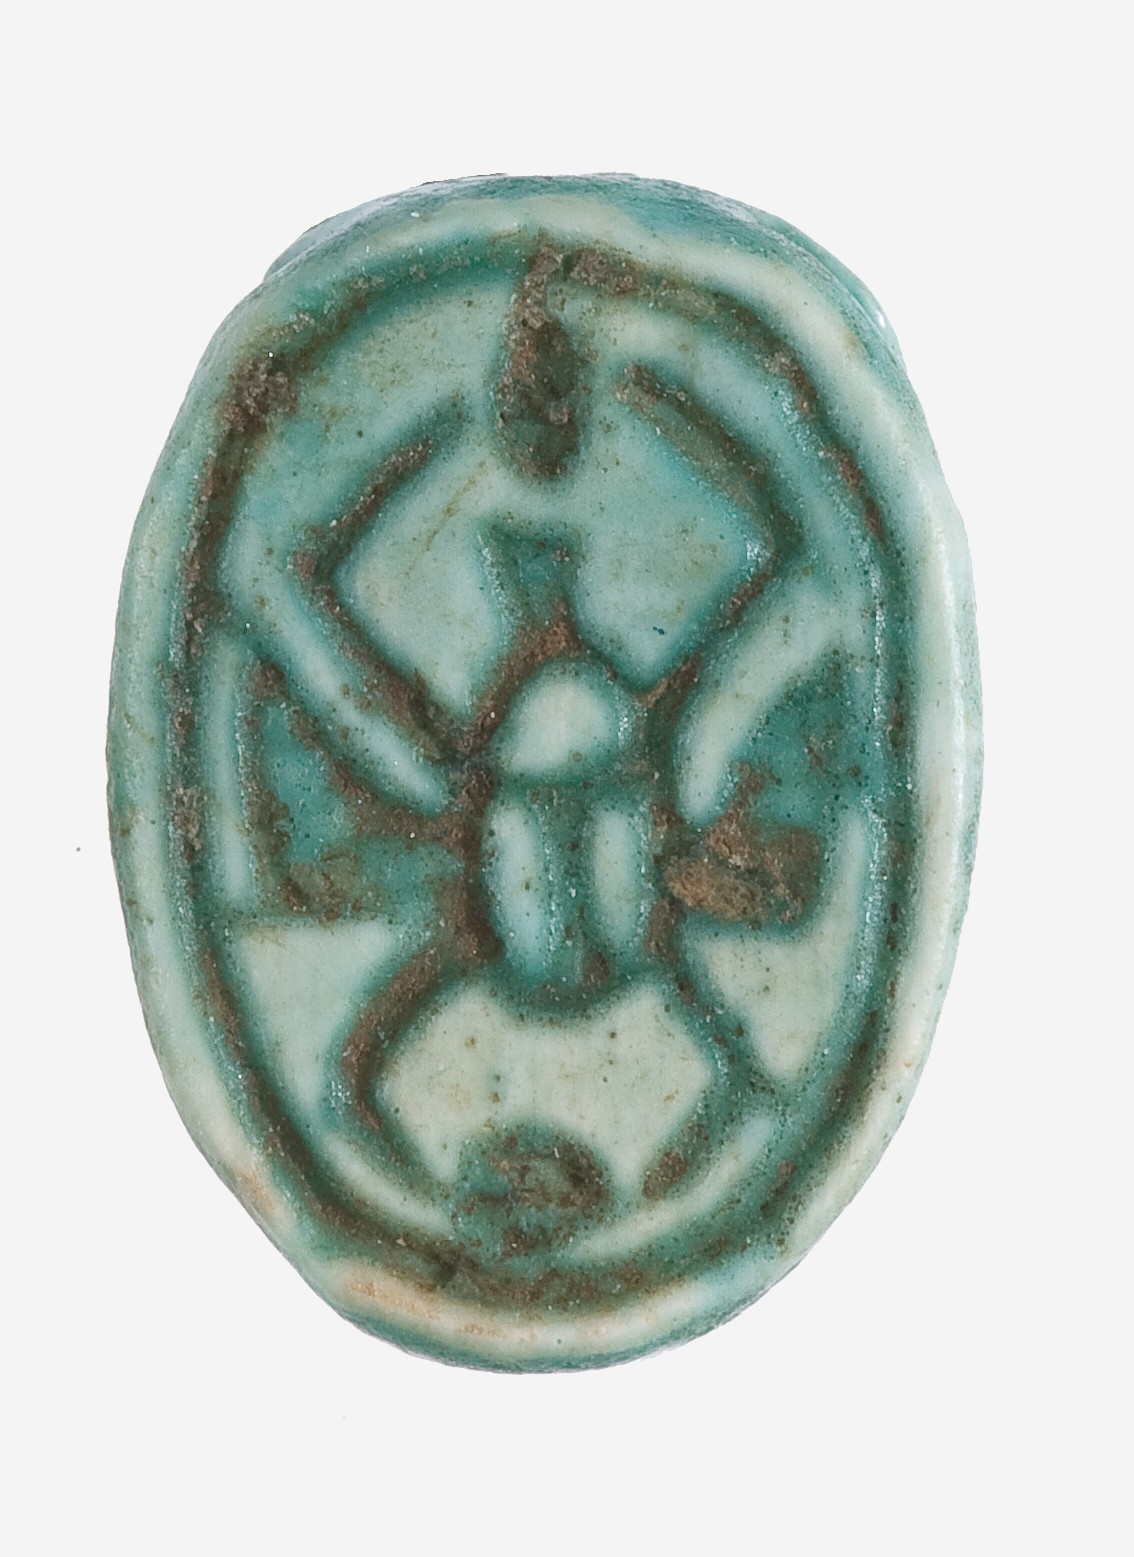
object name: scarab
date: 1640-1504 BCE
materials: stone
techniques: glazing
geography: egypt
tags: scarabs